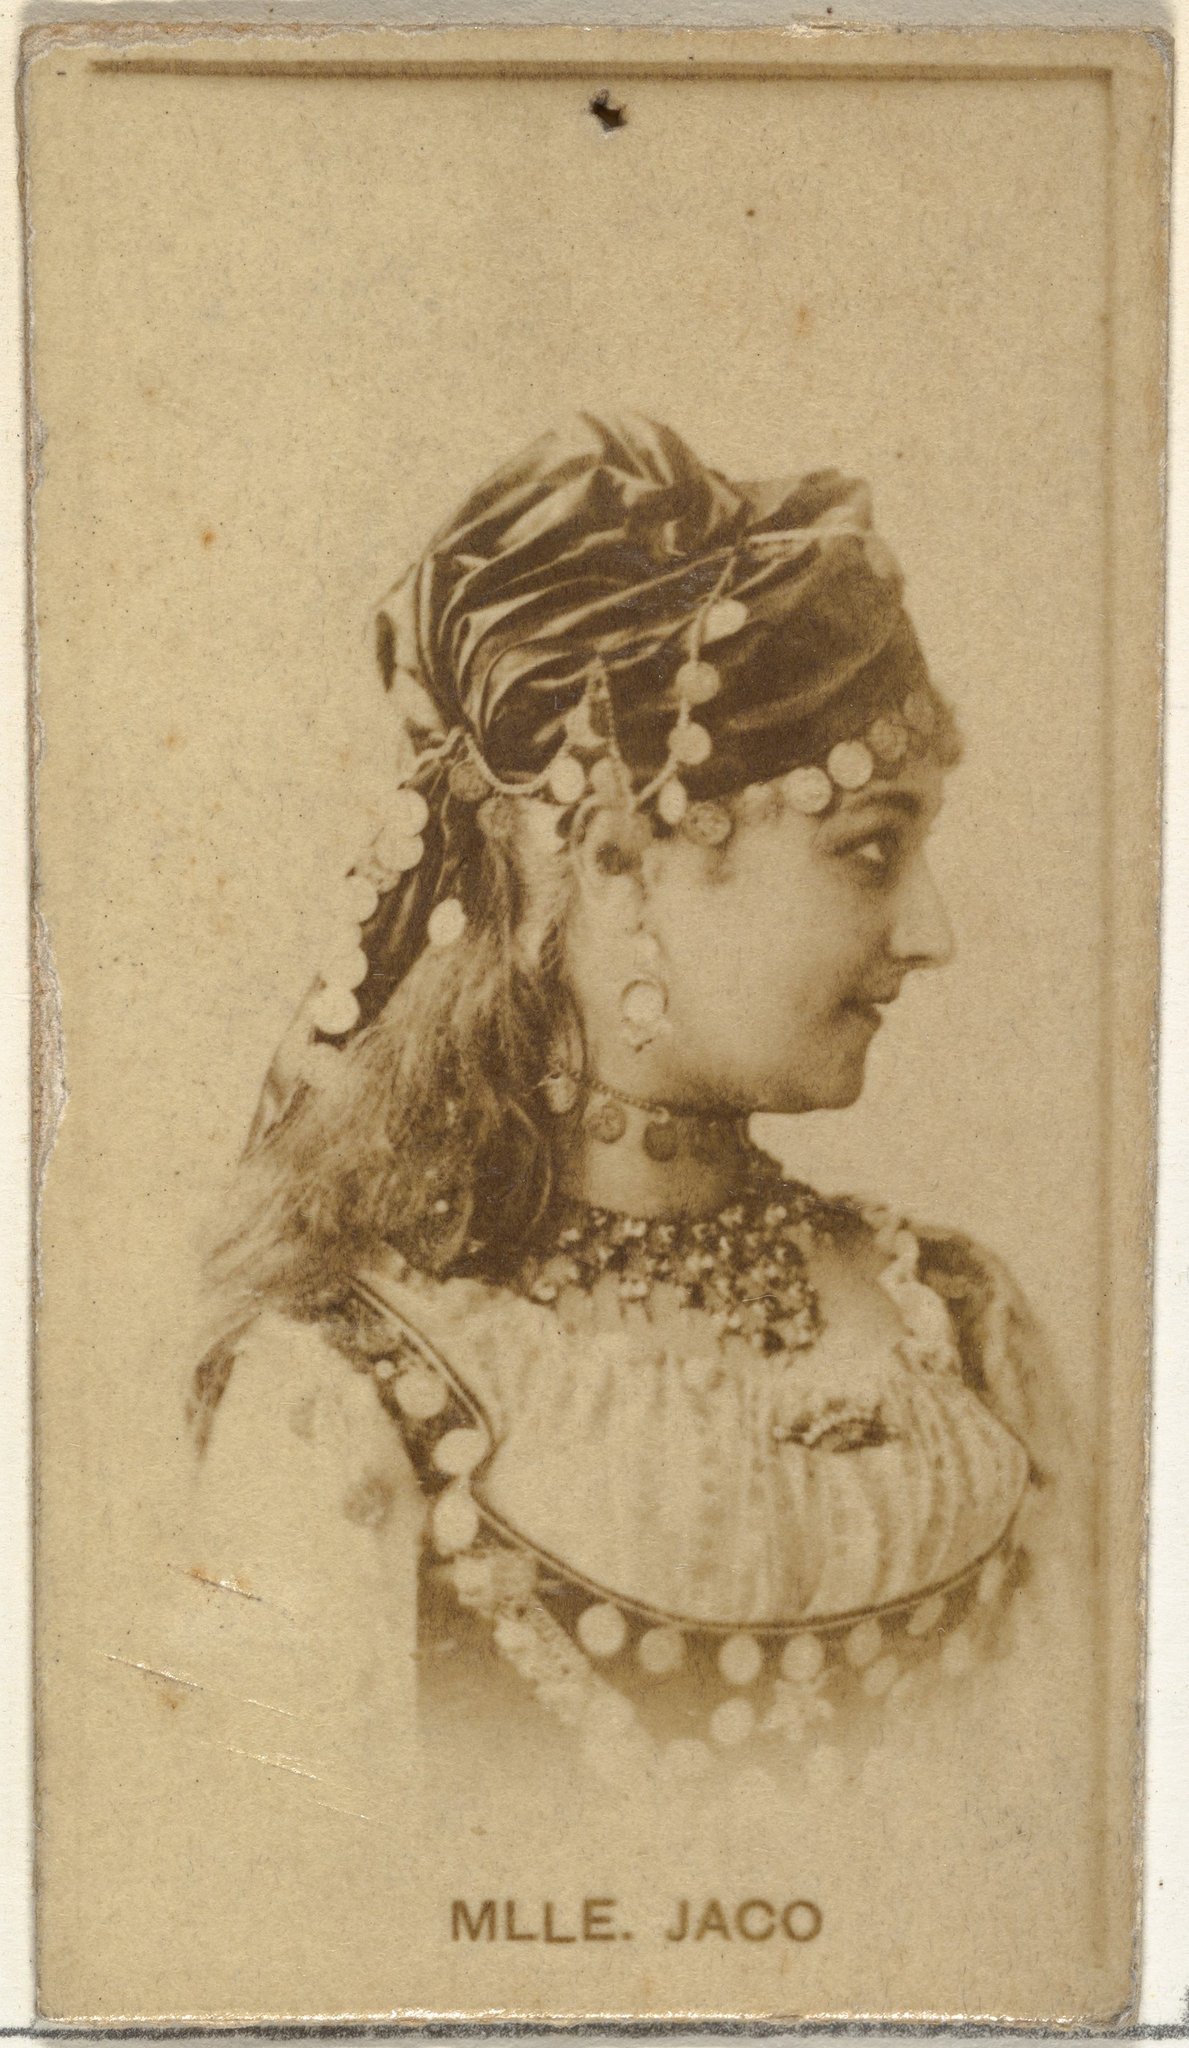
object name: photograph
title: Mlle. Jaco, from the Actors and Actresses series (N145-8) issued by Duke Sons & Co. to promote Duke Cigarettes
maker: w. duke, sons & co.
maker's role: publisher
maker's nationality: american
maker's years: 1870-1920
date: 1891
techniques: albumen silver print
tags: portraits,women,actresses